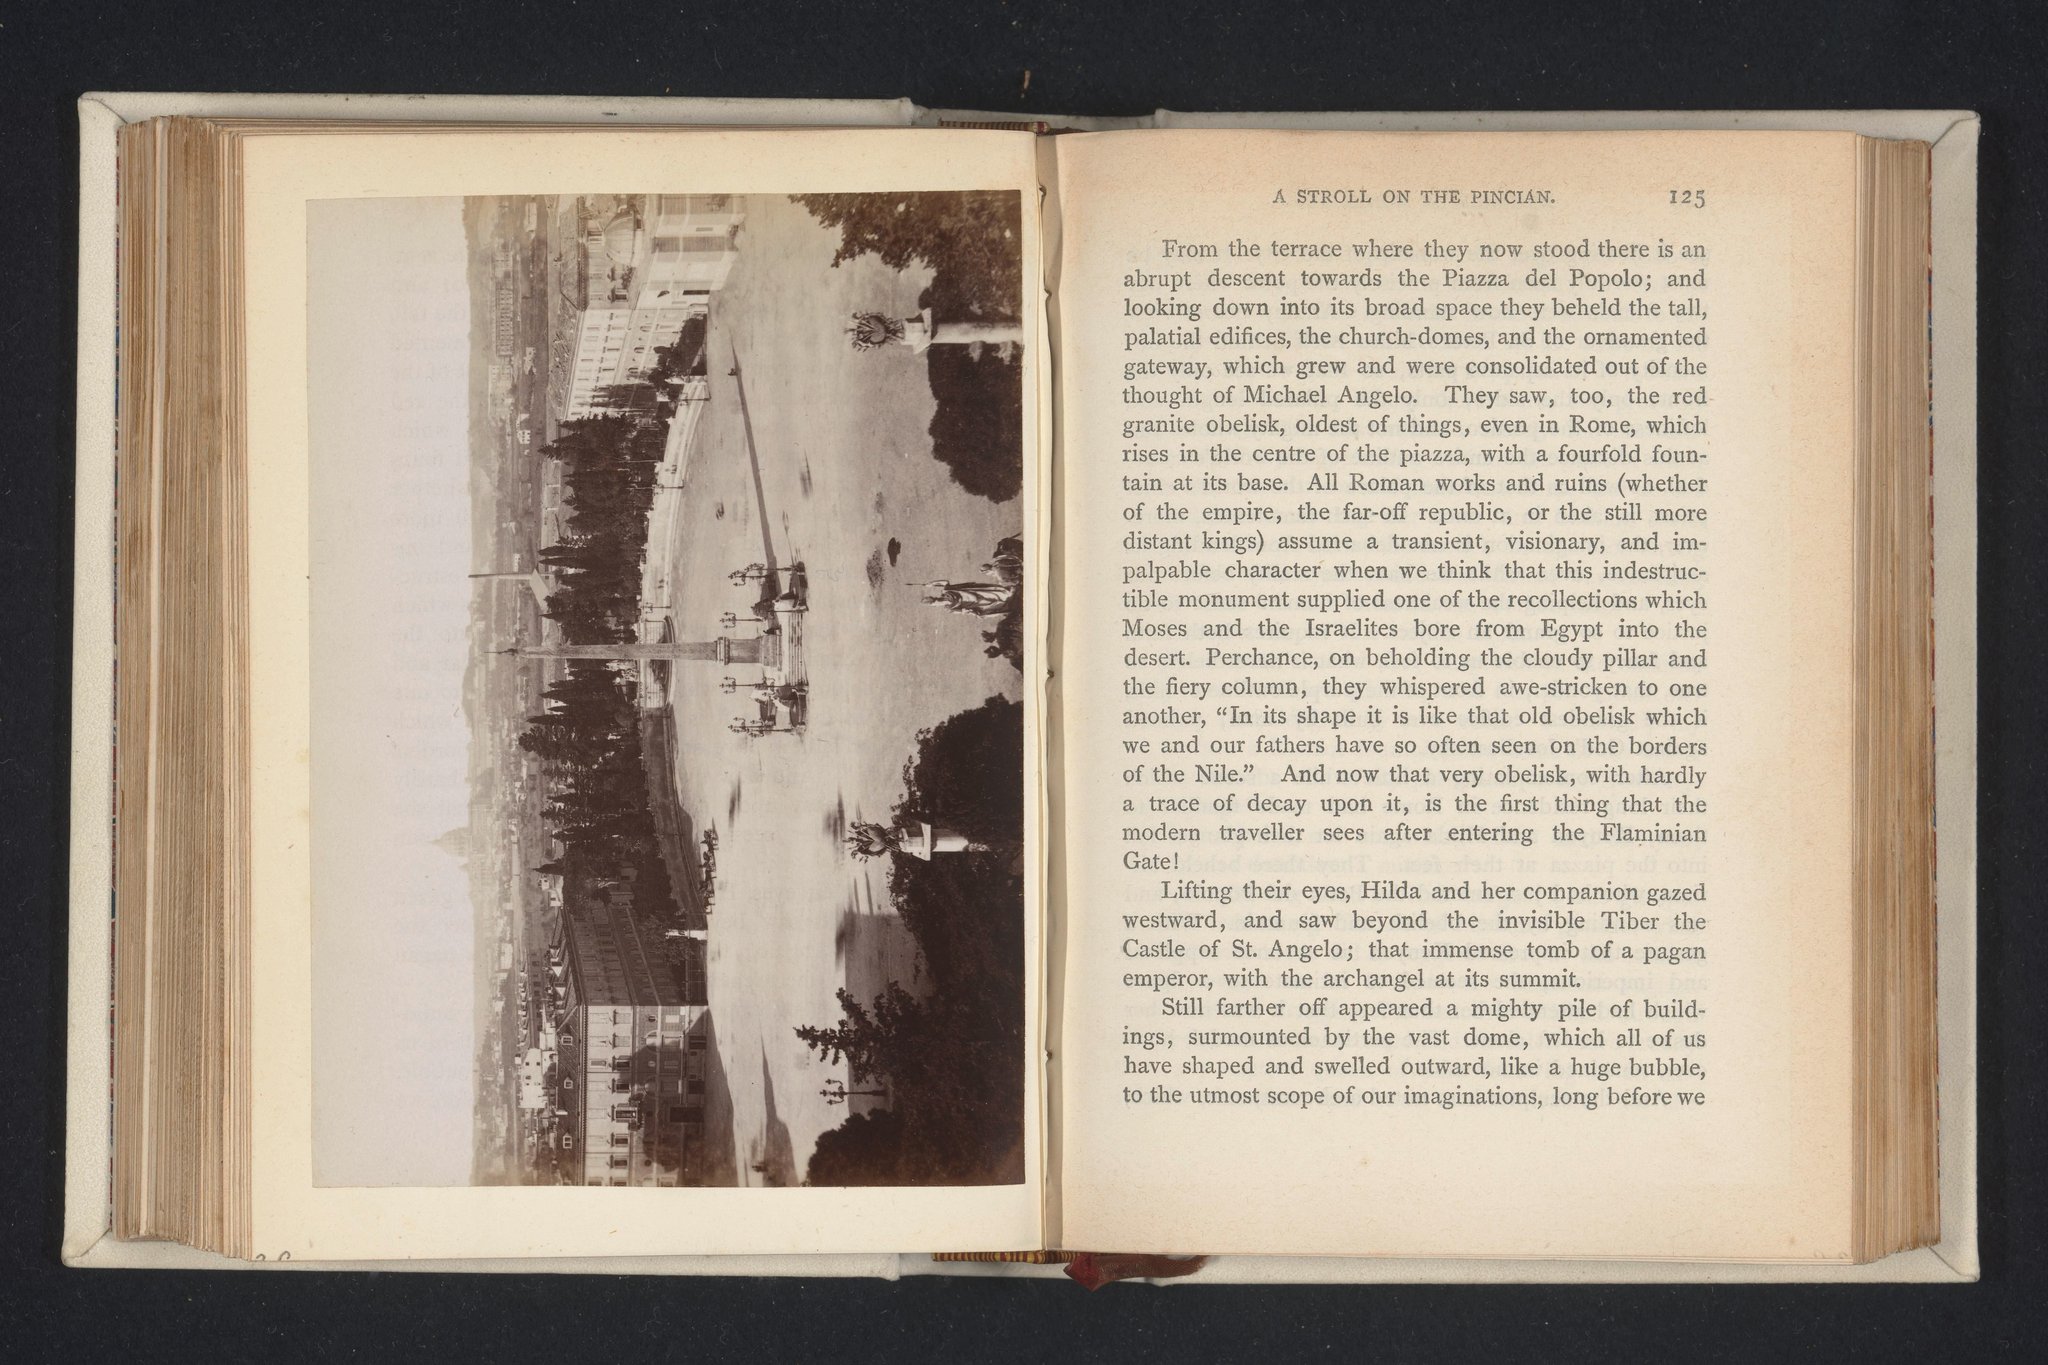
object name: photograph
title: Gezicht over het Piazza del Popolo met de obelisk van Ramses II in Rome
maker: Anonymous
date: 1850-1860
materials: photographic support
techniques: albumen print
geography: rome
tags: square, place, circus, etc., obelisk, needle